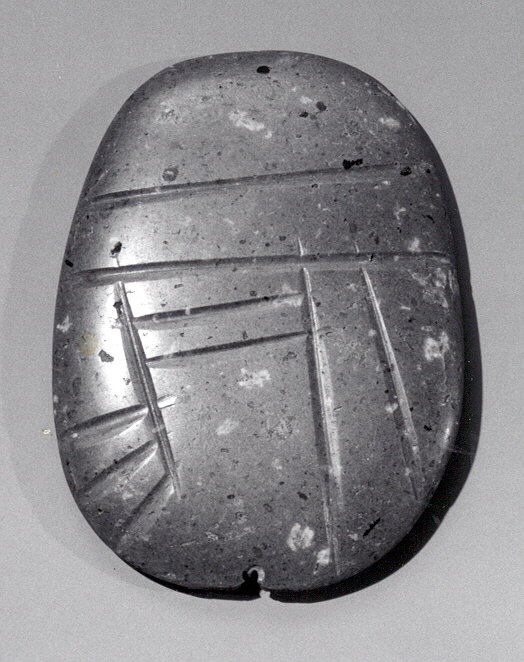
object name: plaque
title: Incised Plaque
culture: mezcala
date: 1-800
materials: stone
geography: mexico